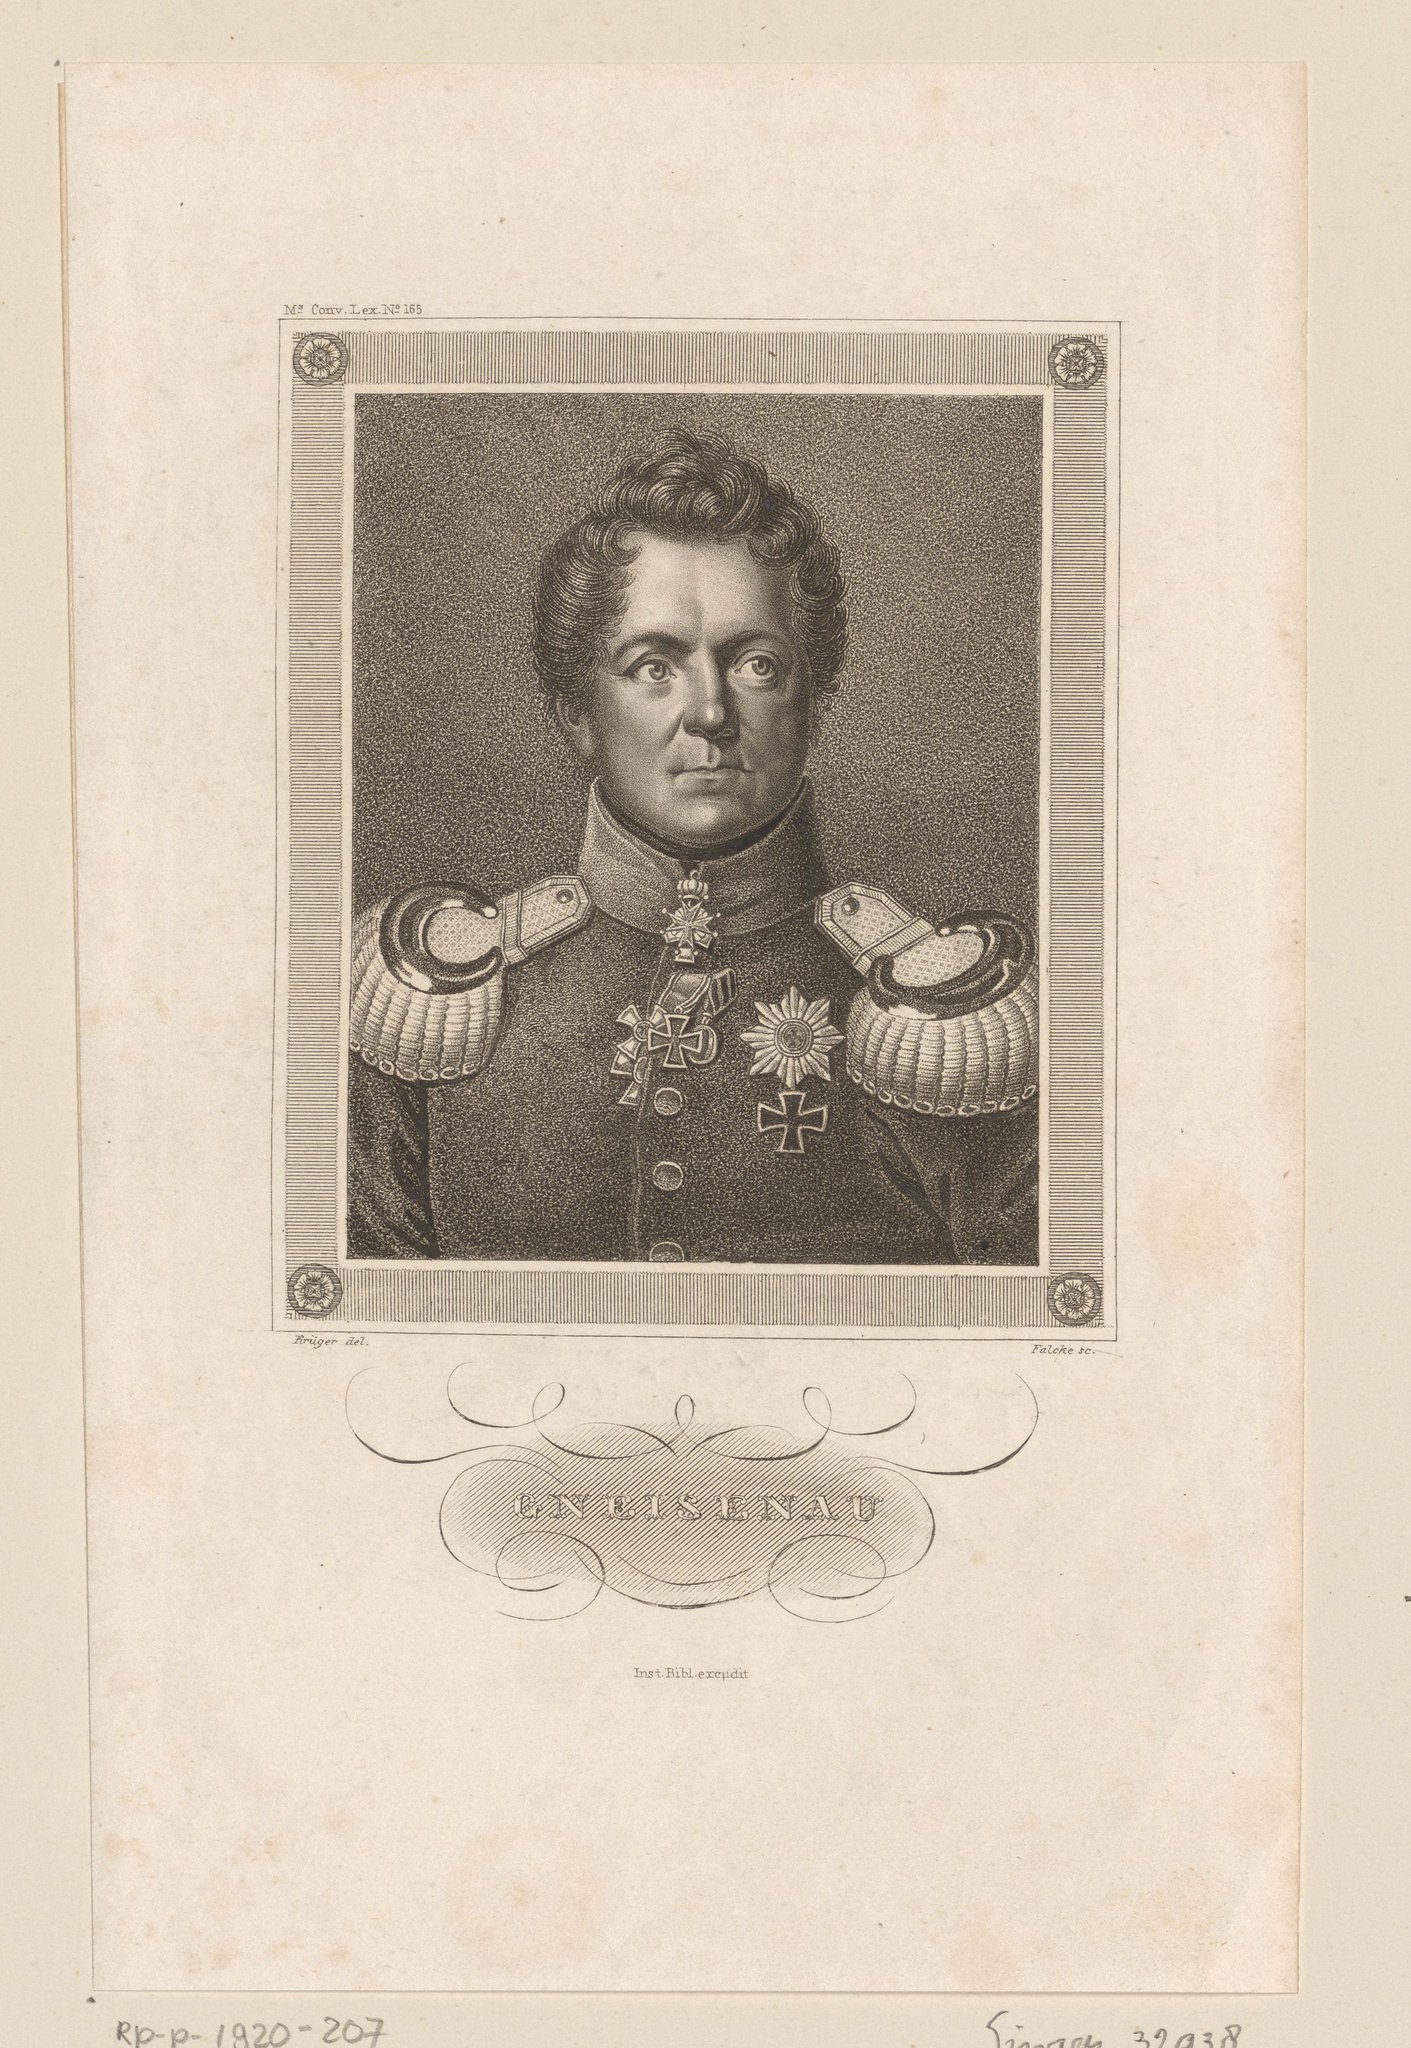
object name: print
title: Portret van August Wilhelm Antonius Neidhardt Graf von Gneisenau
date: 1828-1861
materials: paper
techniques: etching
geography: hildburghausen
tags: knighthood order, commander-in-chief, general, marshal, historical persons, medals and other marks of military honour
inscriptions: collector's mark: Lugt 2228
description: Prent uit: Meyer, Joseph. [Neues] Conversations-Lexikon für die gebildeten Stände. Hildburghausen: Bibliographisches Institut, [1828-1861].